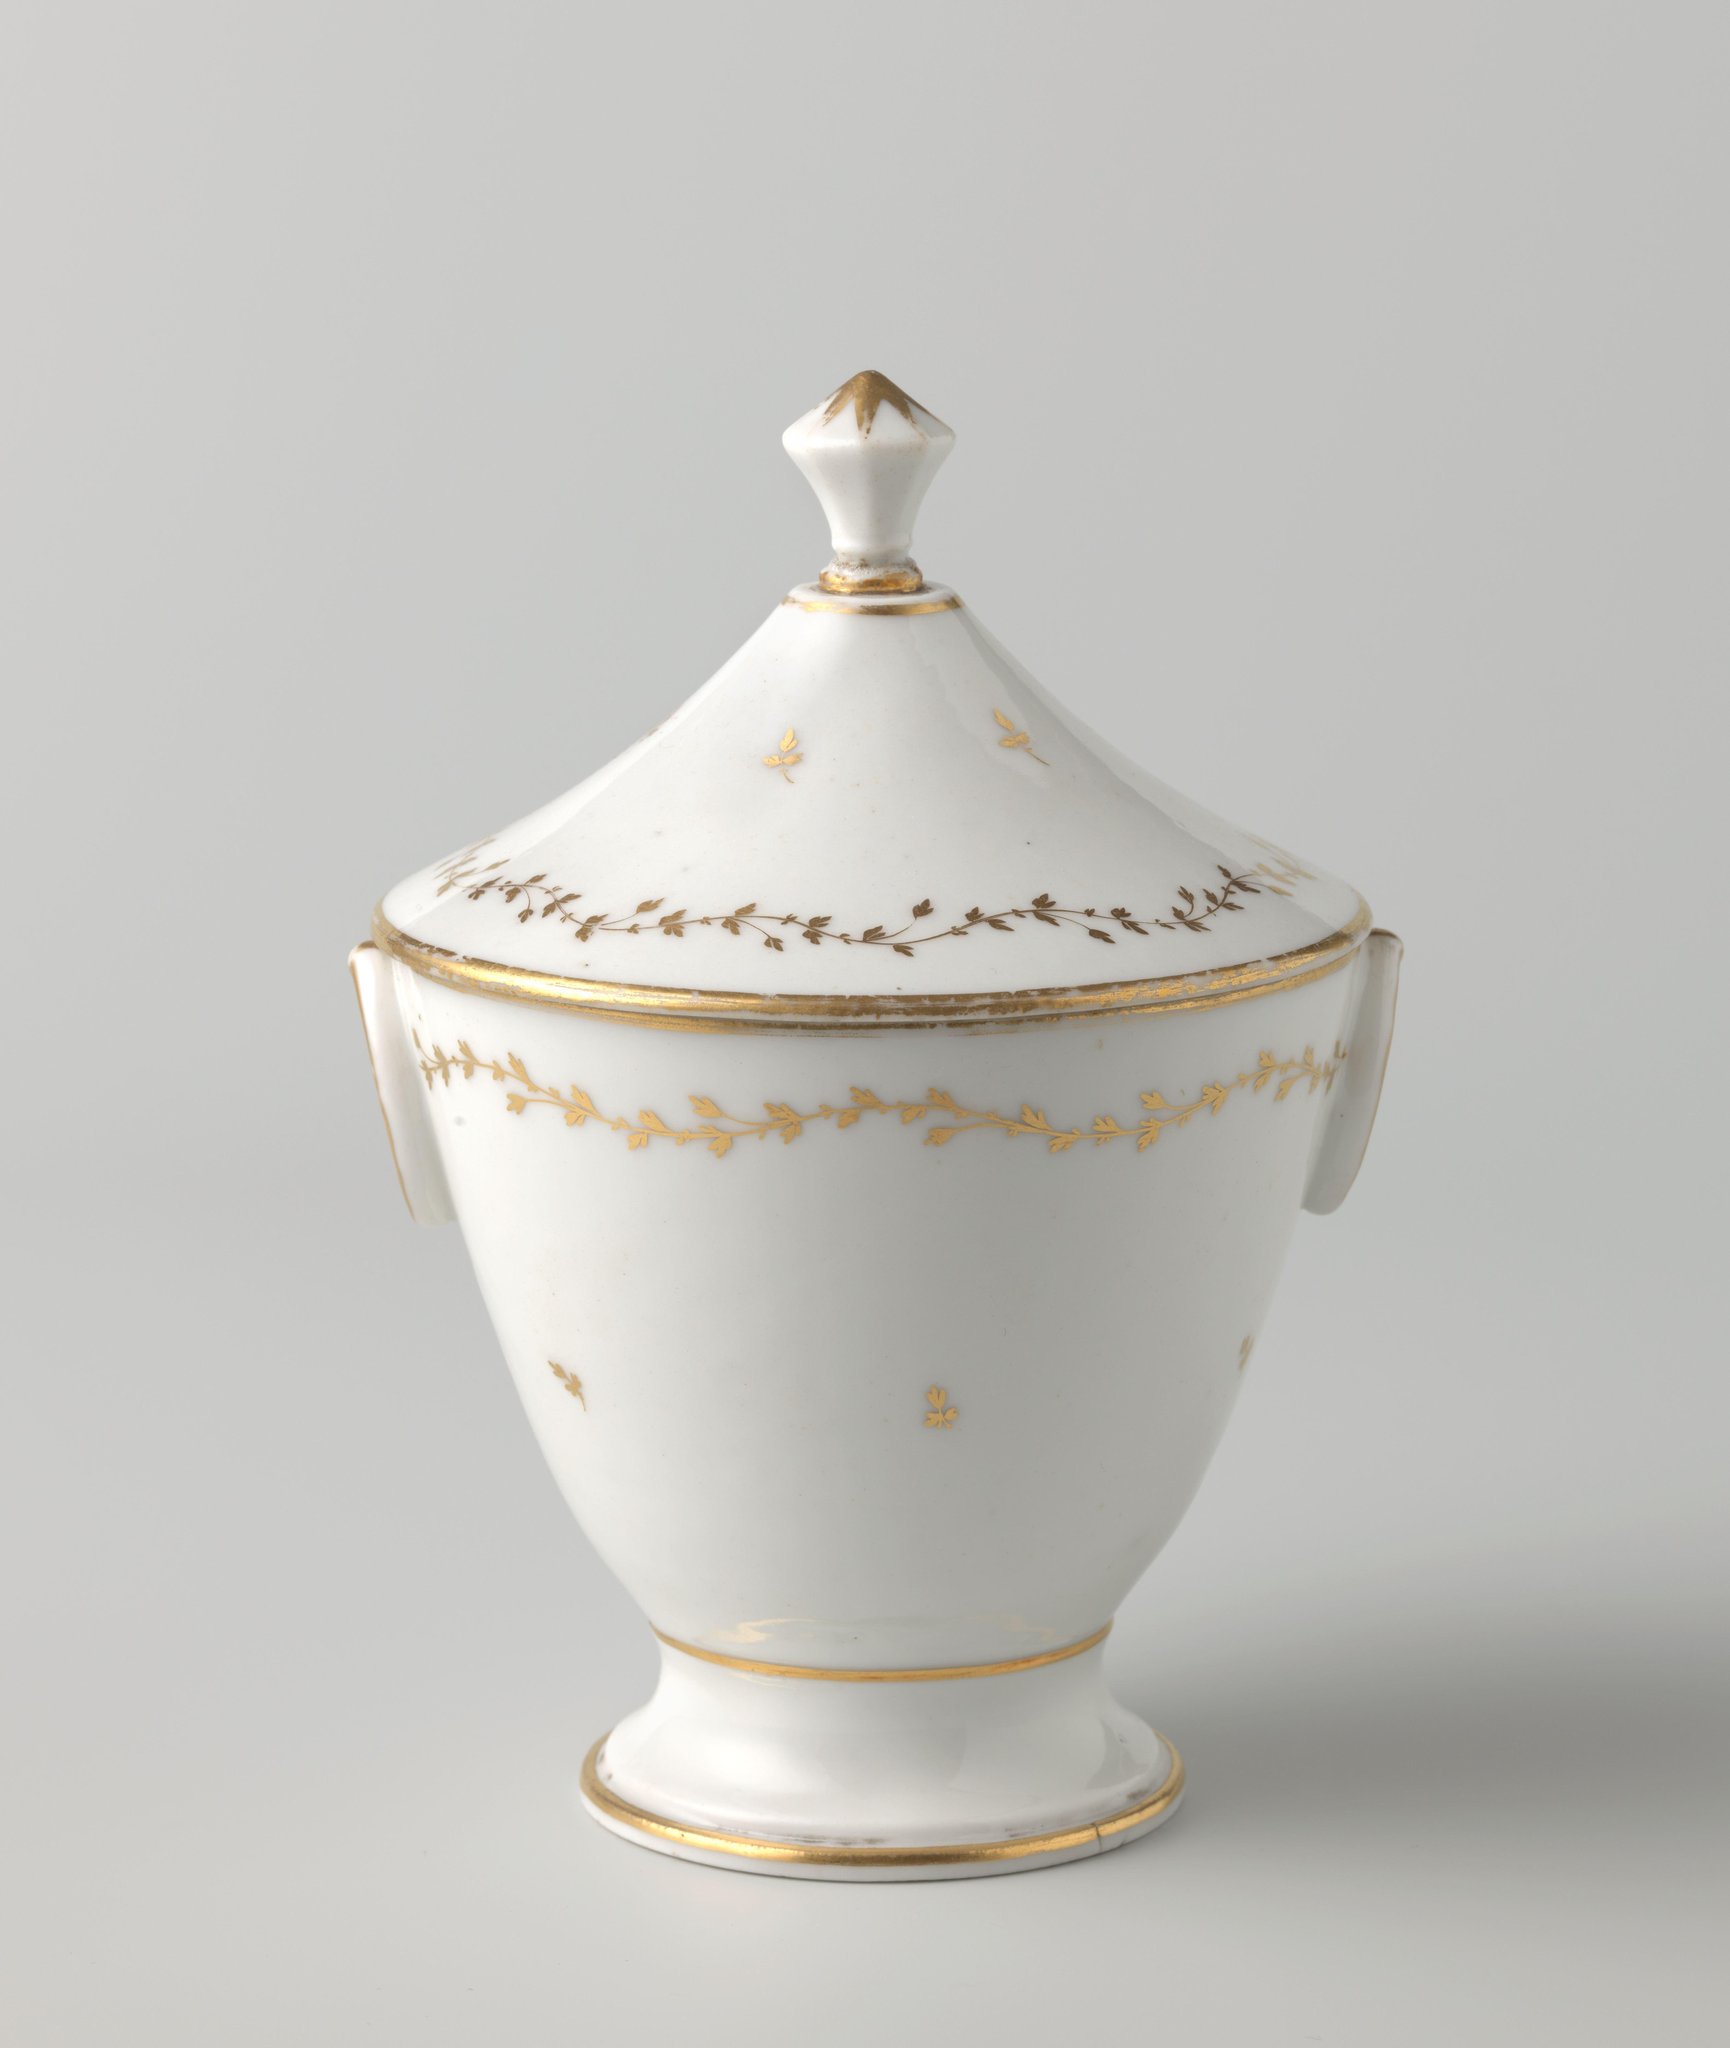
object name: sugar box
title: Suikerpot met deksel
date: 1809-1814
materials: porcelain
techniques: painted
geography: nieuwer-amstel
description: Suikerpot met deksel in Empirestijl. De suikerpot is versierd met bladslingers, strooiblaadjes en gouden biezen langs de randen. Aan beide zijden liggen vast de pot ovale ringen. De holle kegelvormige deksel heeft een hoge octagonale knop. De voet van de suikerkan is hol gewelfd.